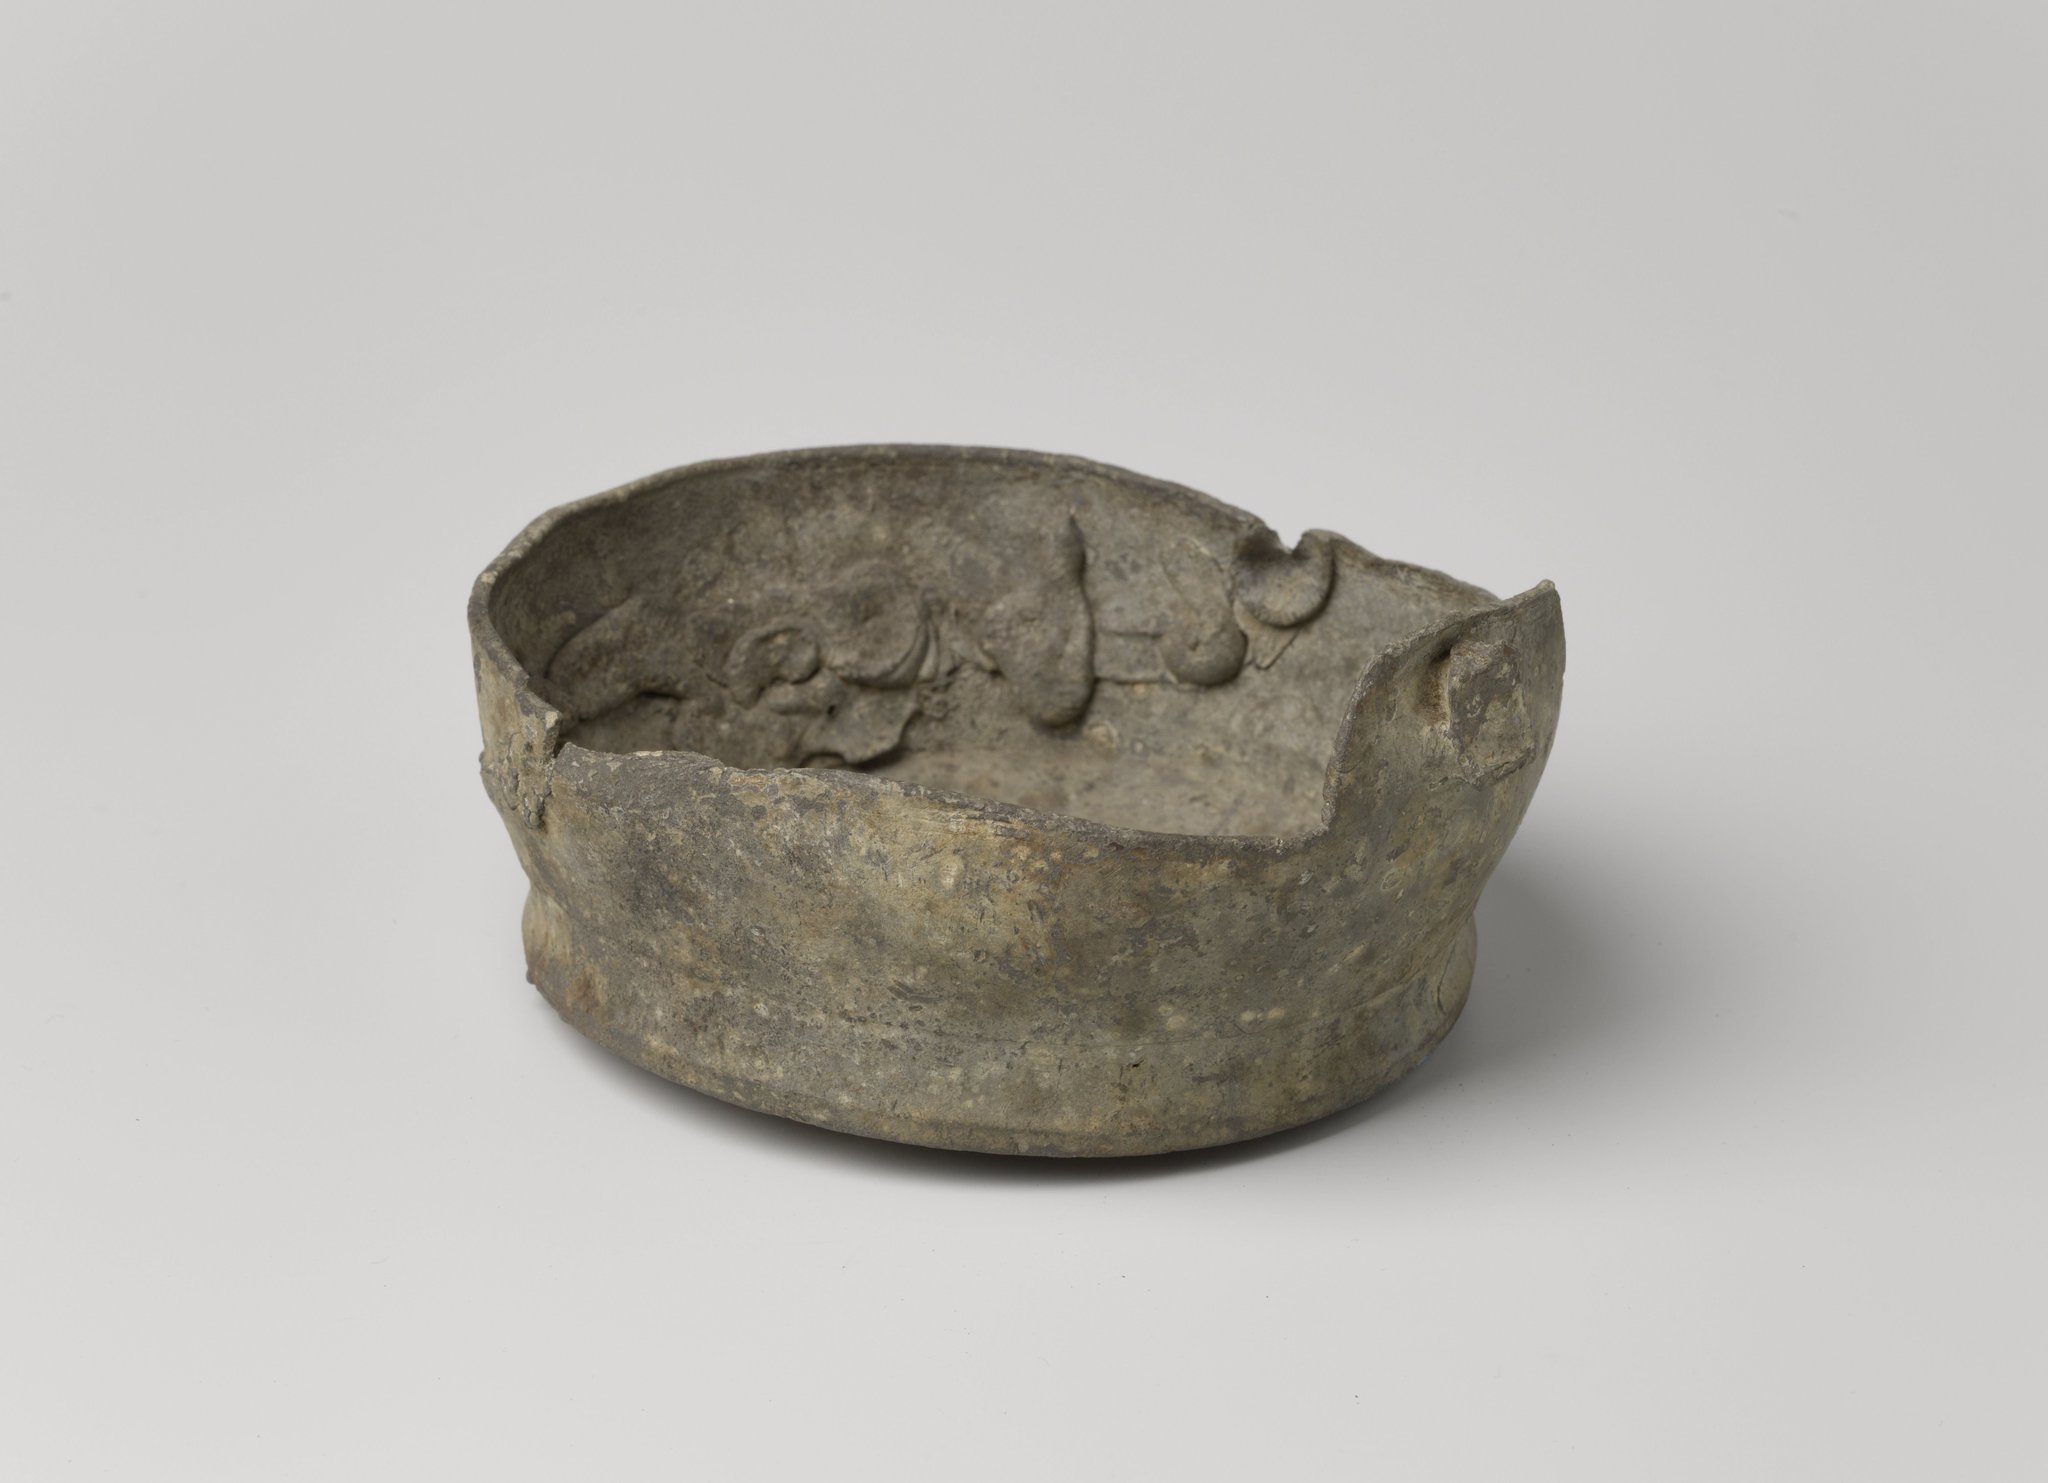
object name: fragment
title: Onderste gedeelte van een tinnen bierkan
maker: Anonymous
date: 1590-1596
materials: tin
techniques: soldering, striking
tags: willem barendsz., amsterdam, jacob van heemskerck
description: Onderste gedeelte van een tinnen bierkan en restant van aangesoldeerd handvat.